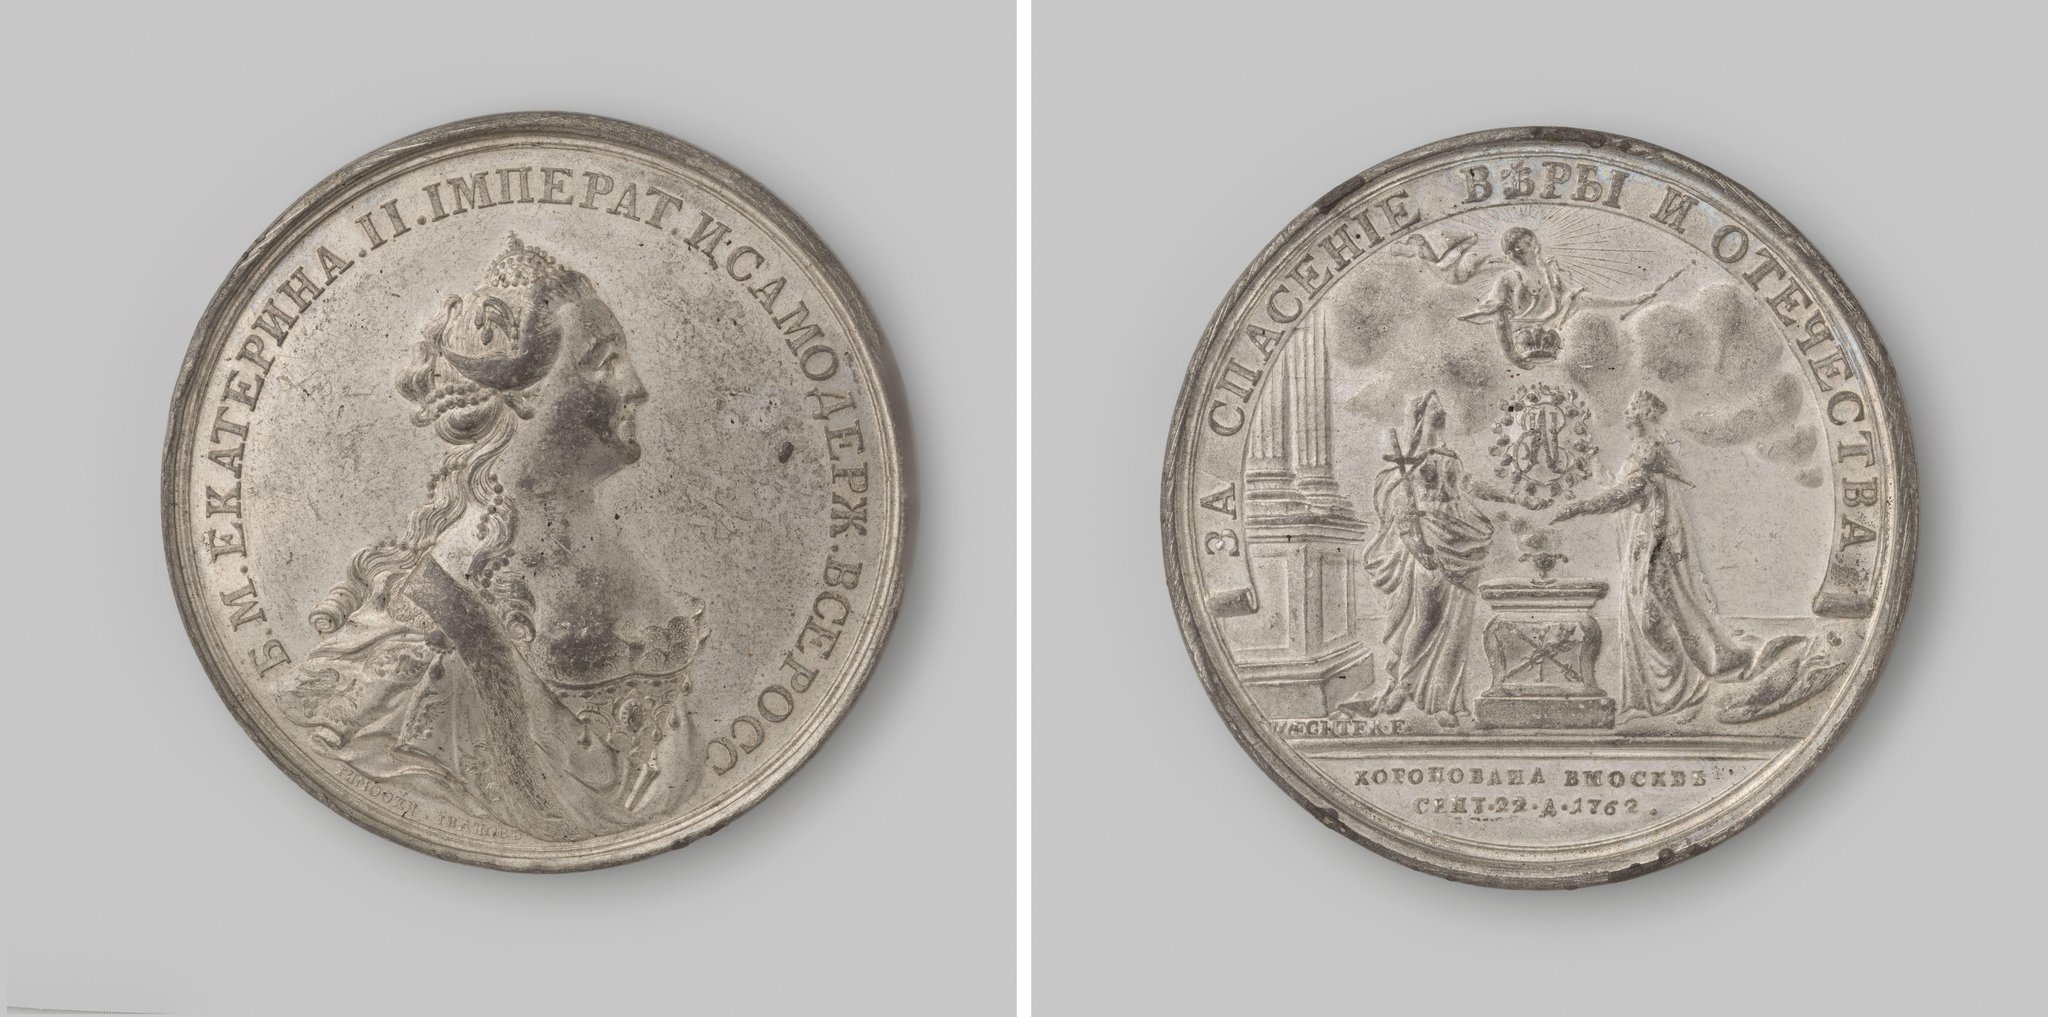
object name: history medal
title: Kroning van Tsarina Catherina de Grote te Moskou 1762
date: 1762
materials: metal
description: Tinnen penning, op de voorzijde het borstbeeld van Tsarina Catherina naar rechts met omschrift, op de keerzijde Catherina die van Pietas boven een altaar een omkranst monogram ontvangt, gekroond door Providentia vanuit de wolken, met links twee zuilen op een voetstuk, met omschrift en afsnedetekst.